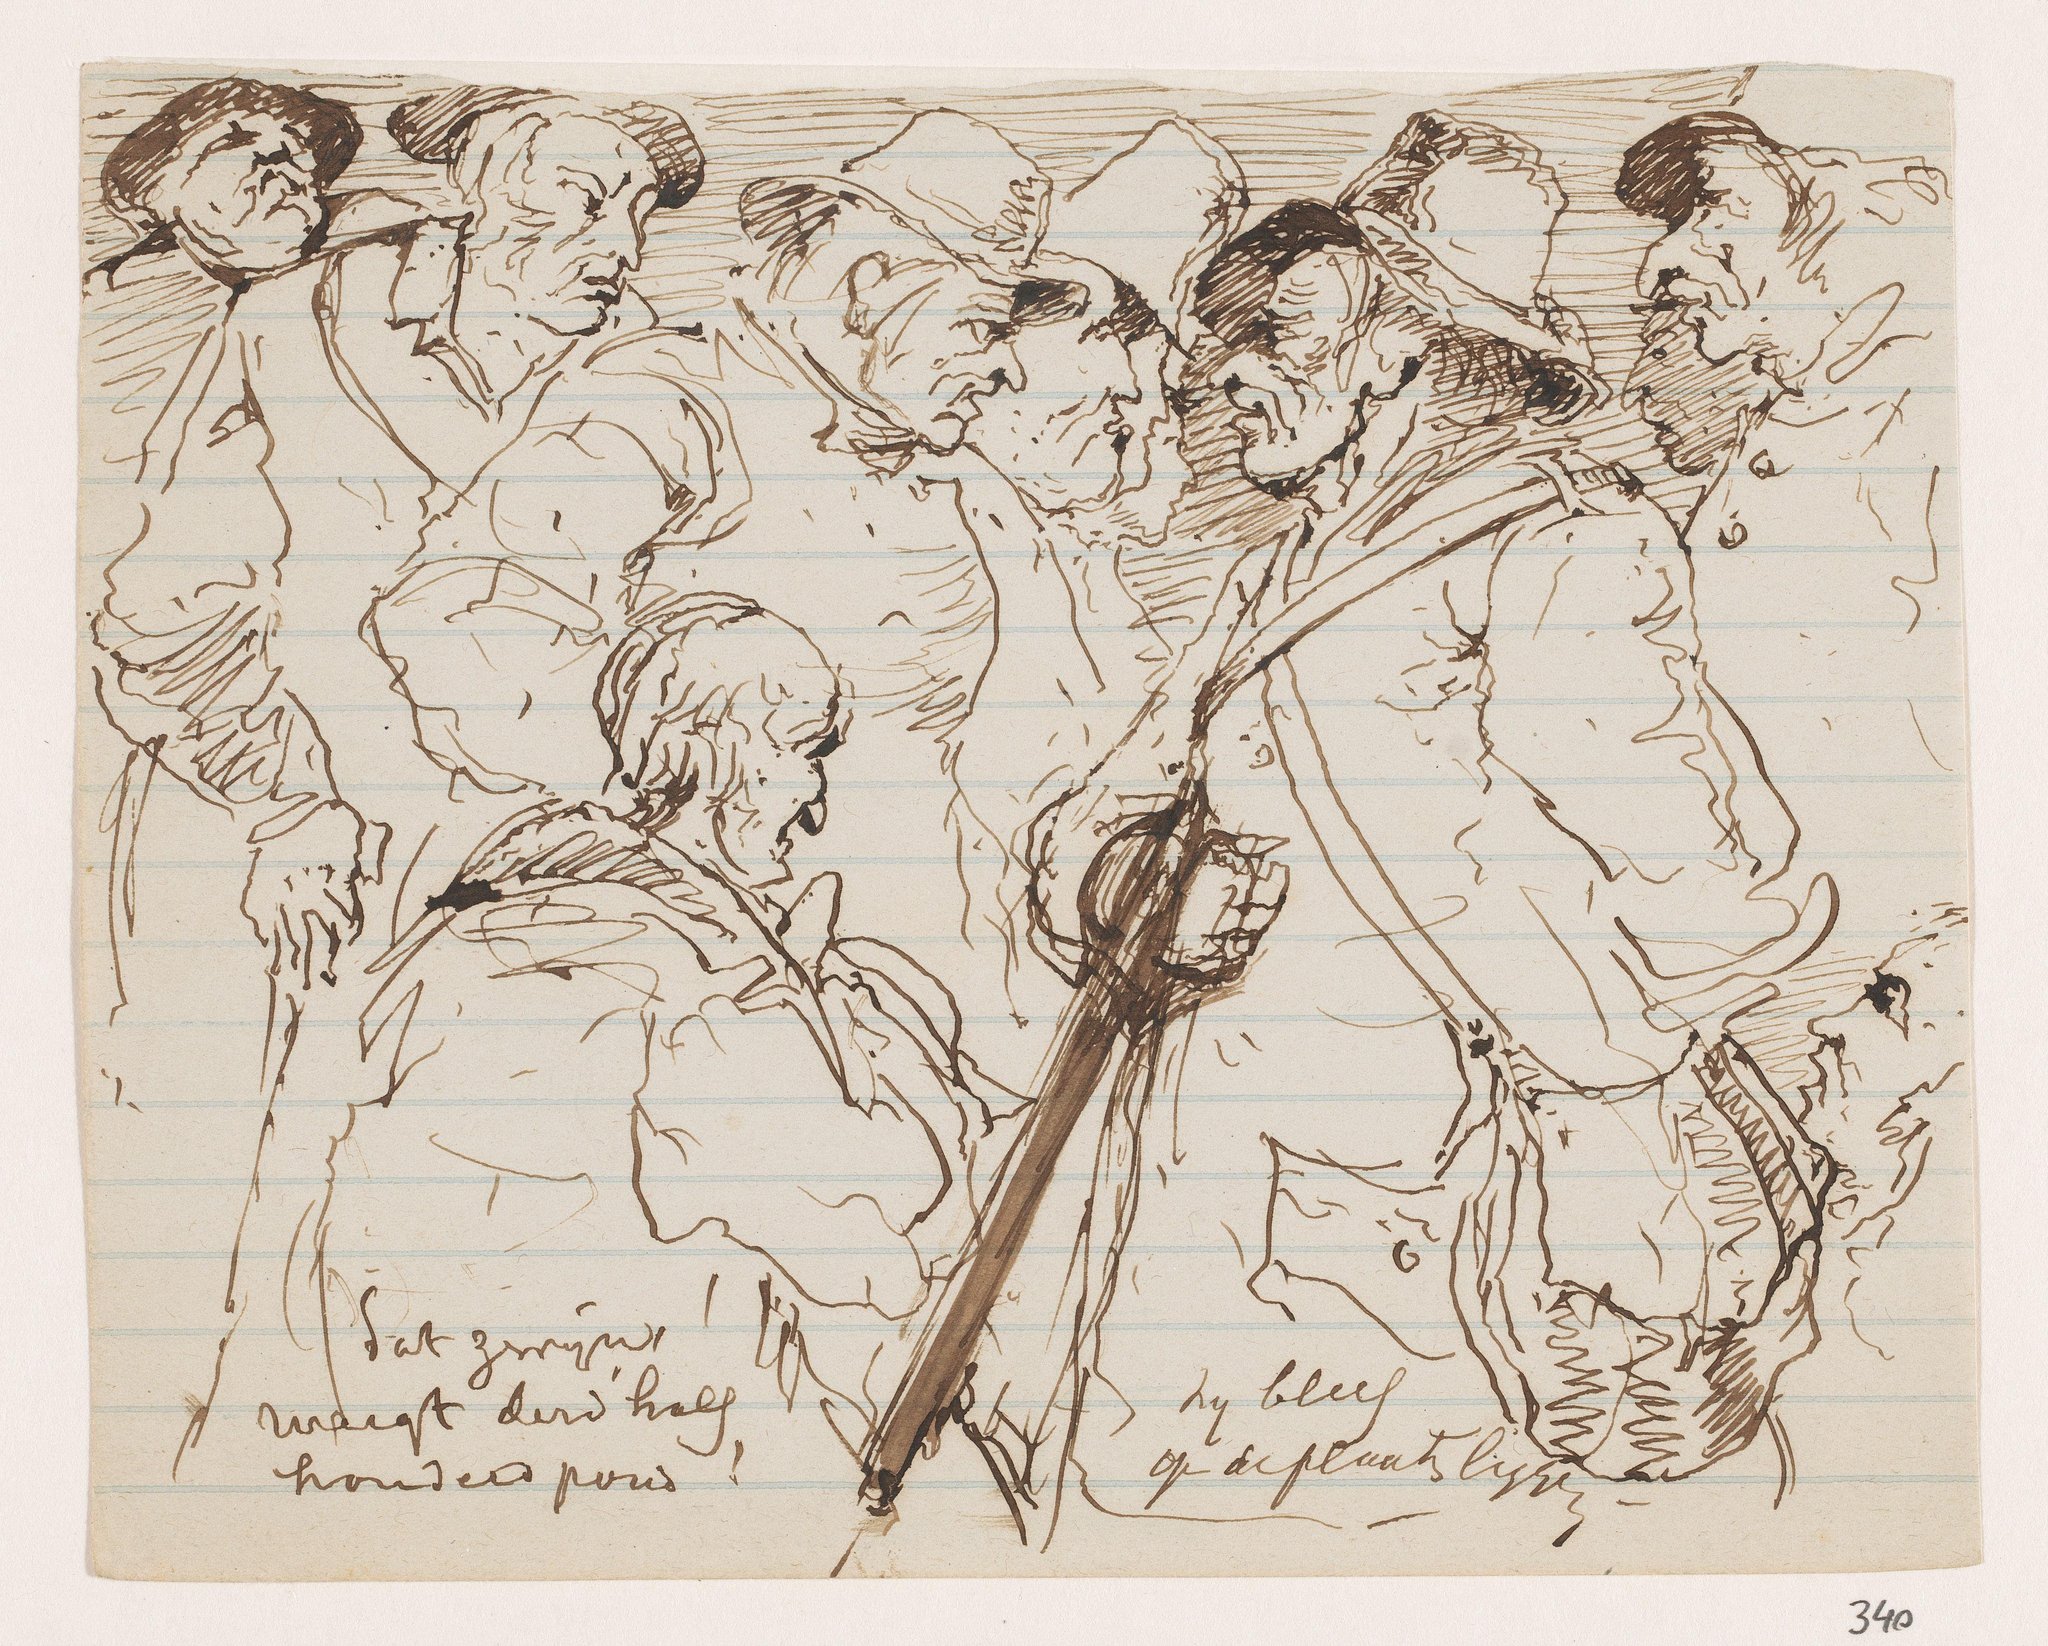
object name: drawing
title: Jagers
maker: johannes tavenraat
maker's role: draughtsman, painter, print maker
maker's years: 1809-1881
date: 1840-1880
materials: ink, paper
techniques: brush, pen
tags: hunter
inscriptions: collector's mark: Lugt 2228, annotation: ‘dat zwijntje weegt derd'half honderd pond! / hij bleef op de plaats liggen’